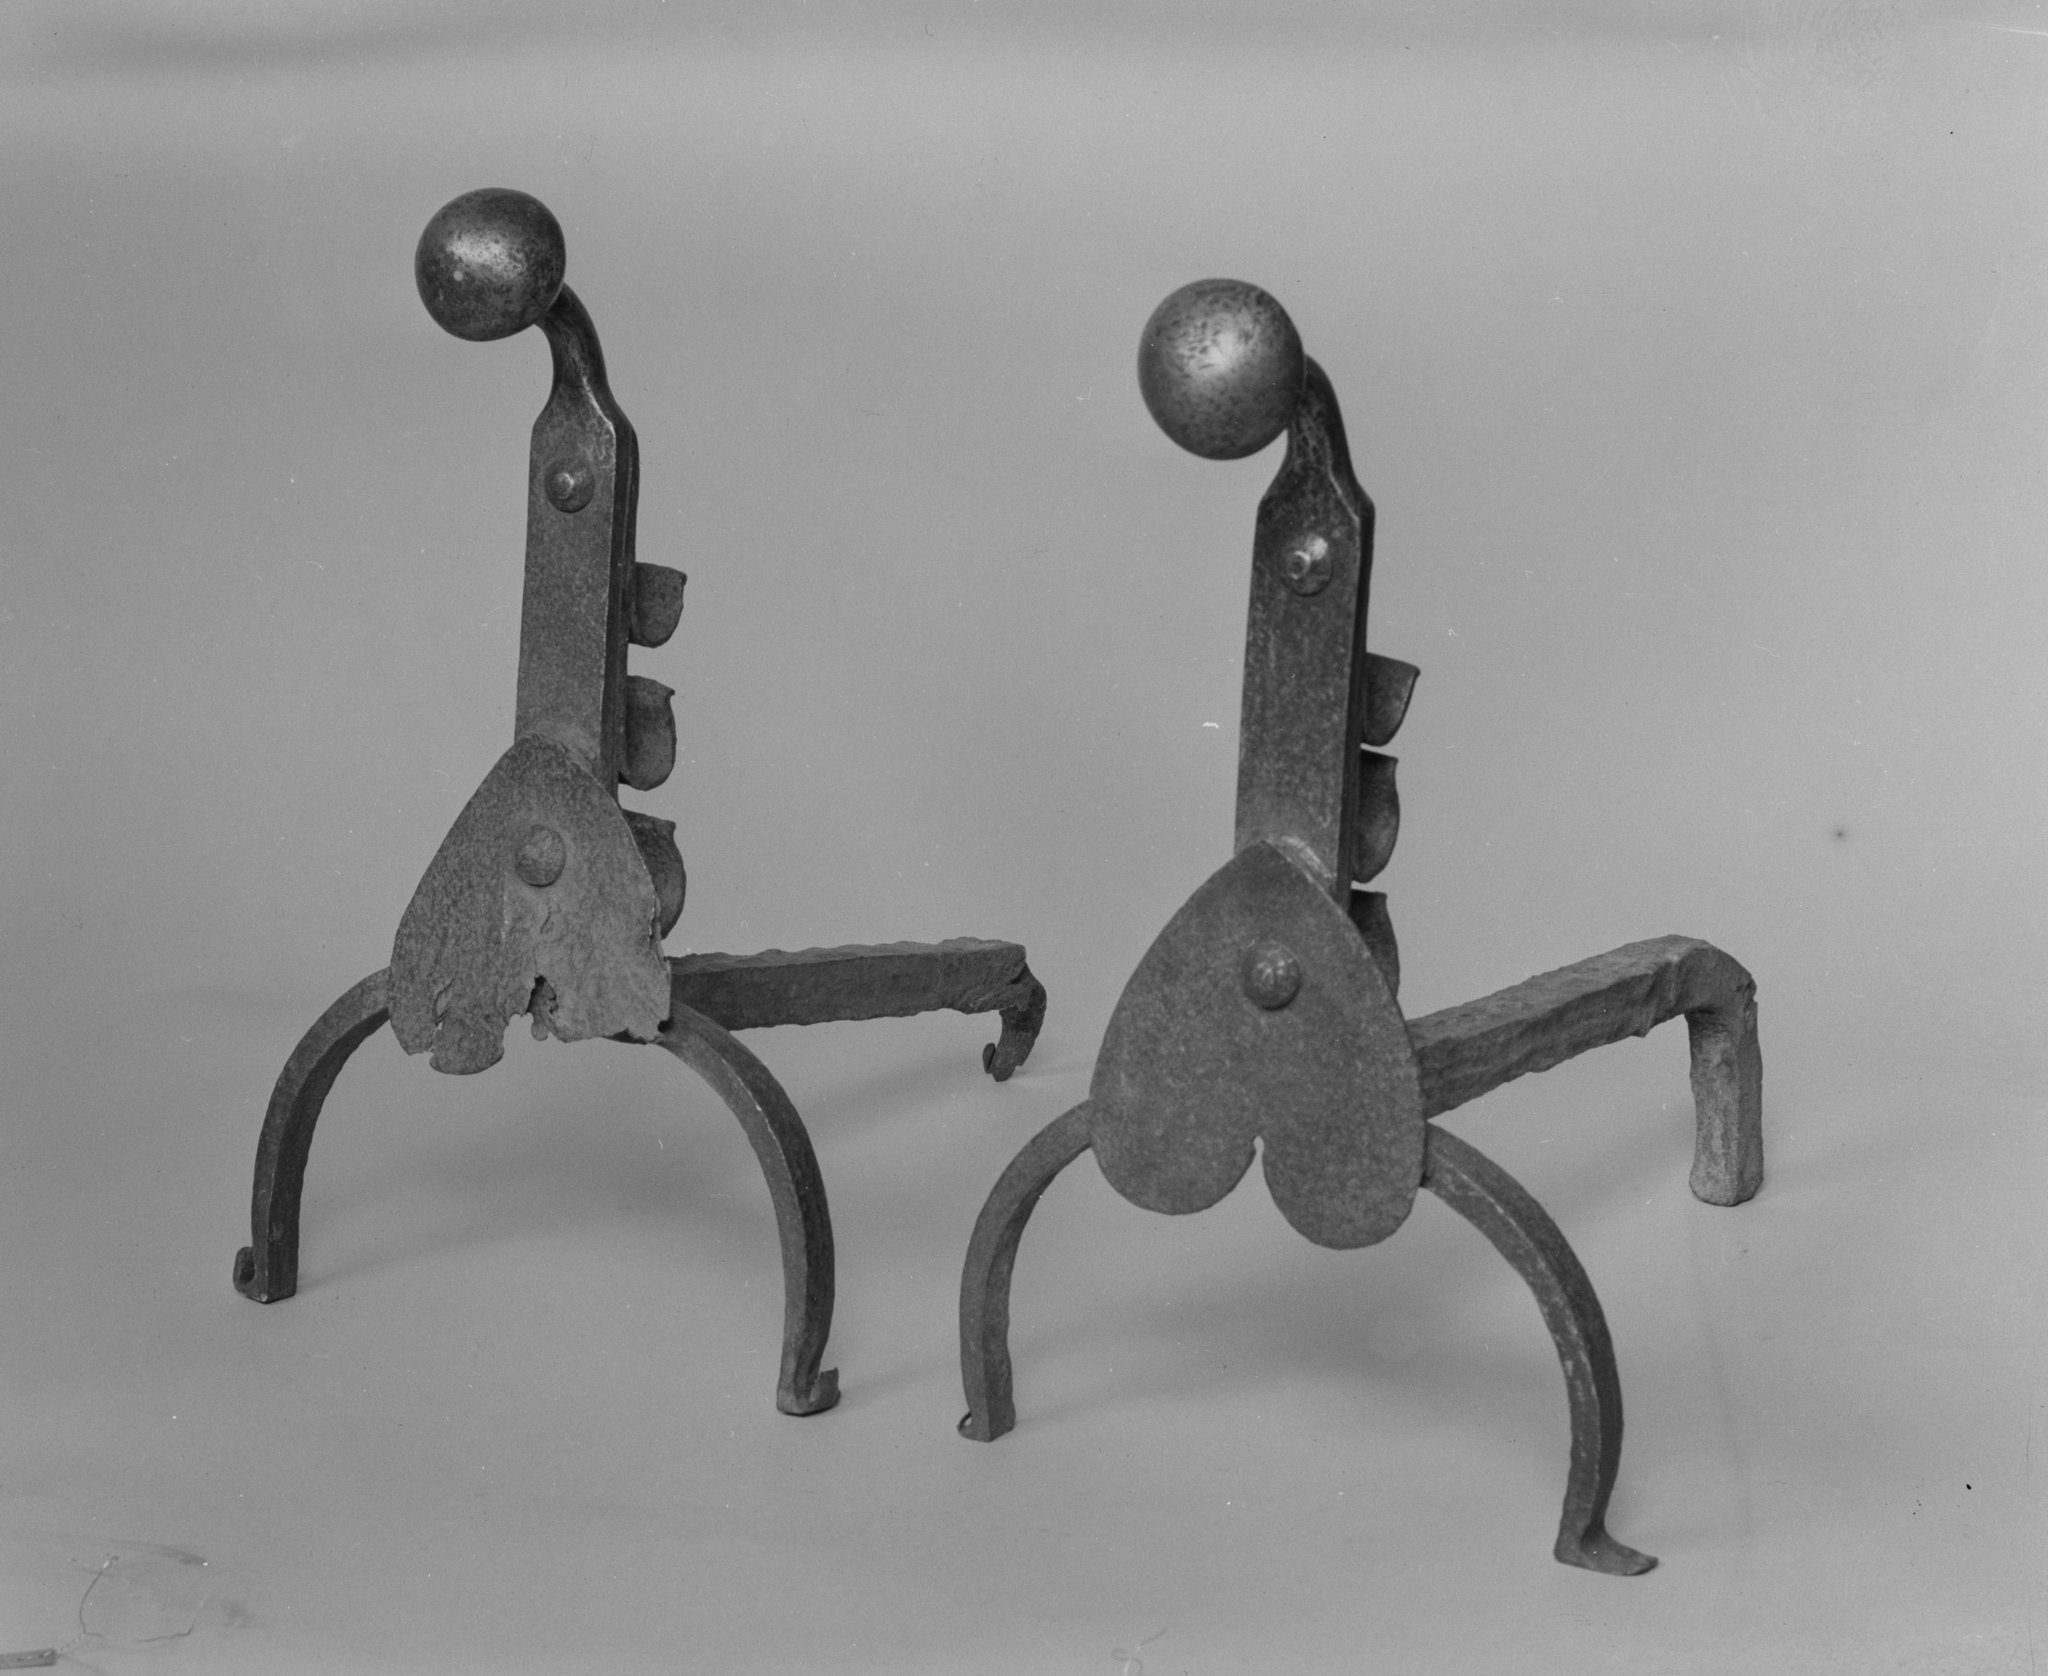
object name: andiron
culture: american or british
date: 1700-1800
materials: iron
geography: england